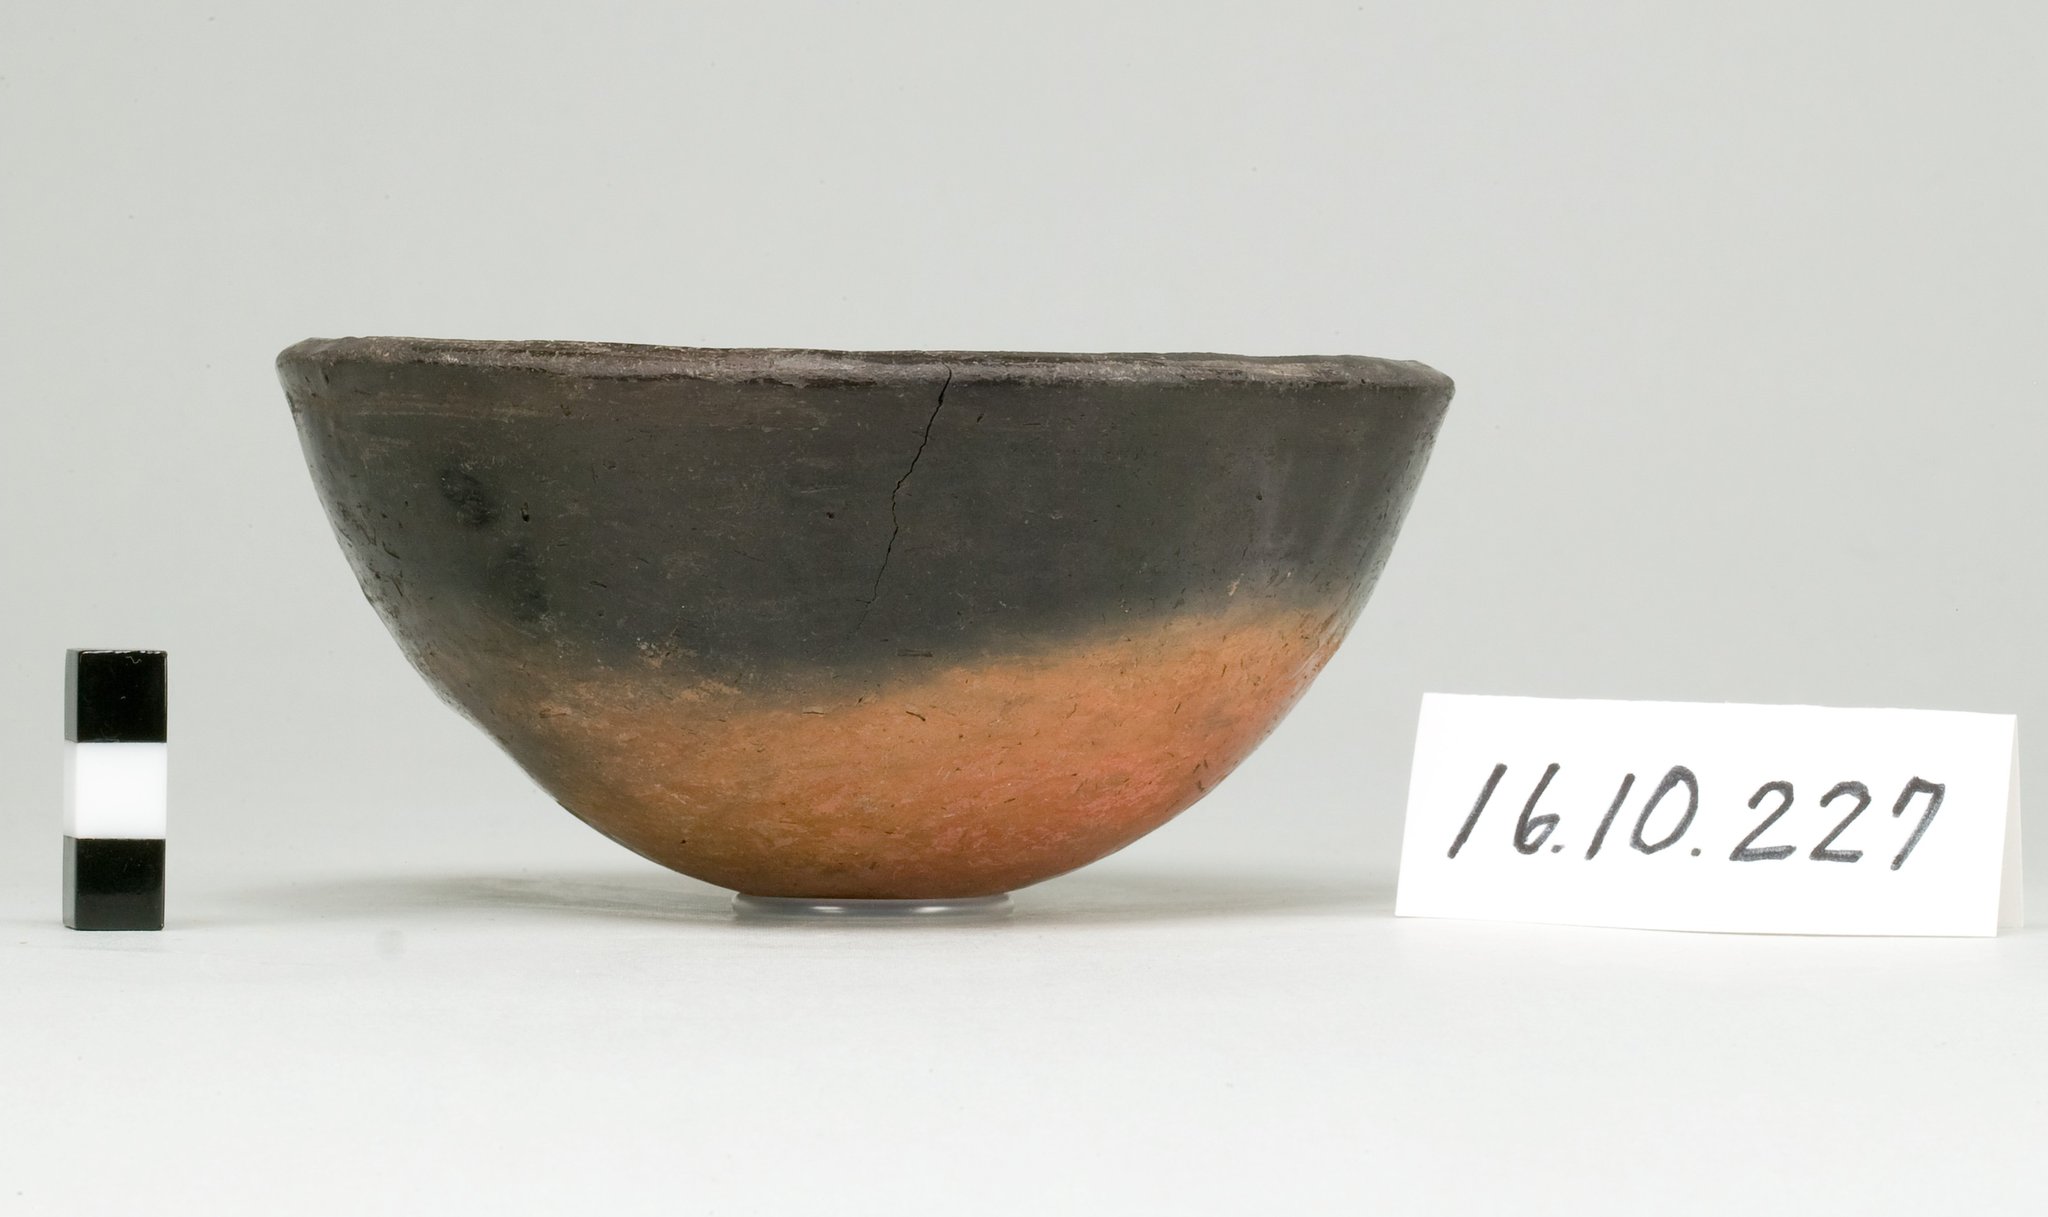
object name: bowl, kerma ware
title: Kerma ware bowl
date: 1635-1458 BCE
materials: pottery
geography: egypt